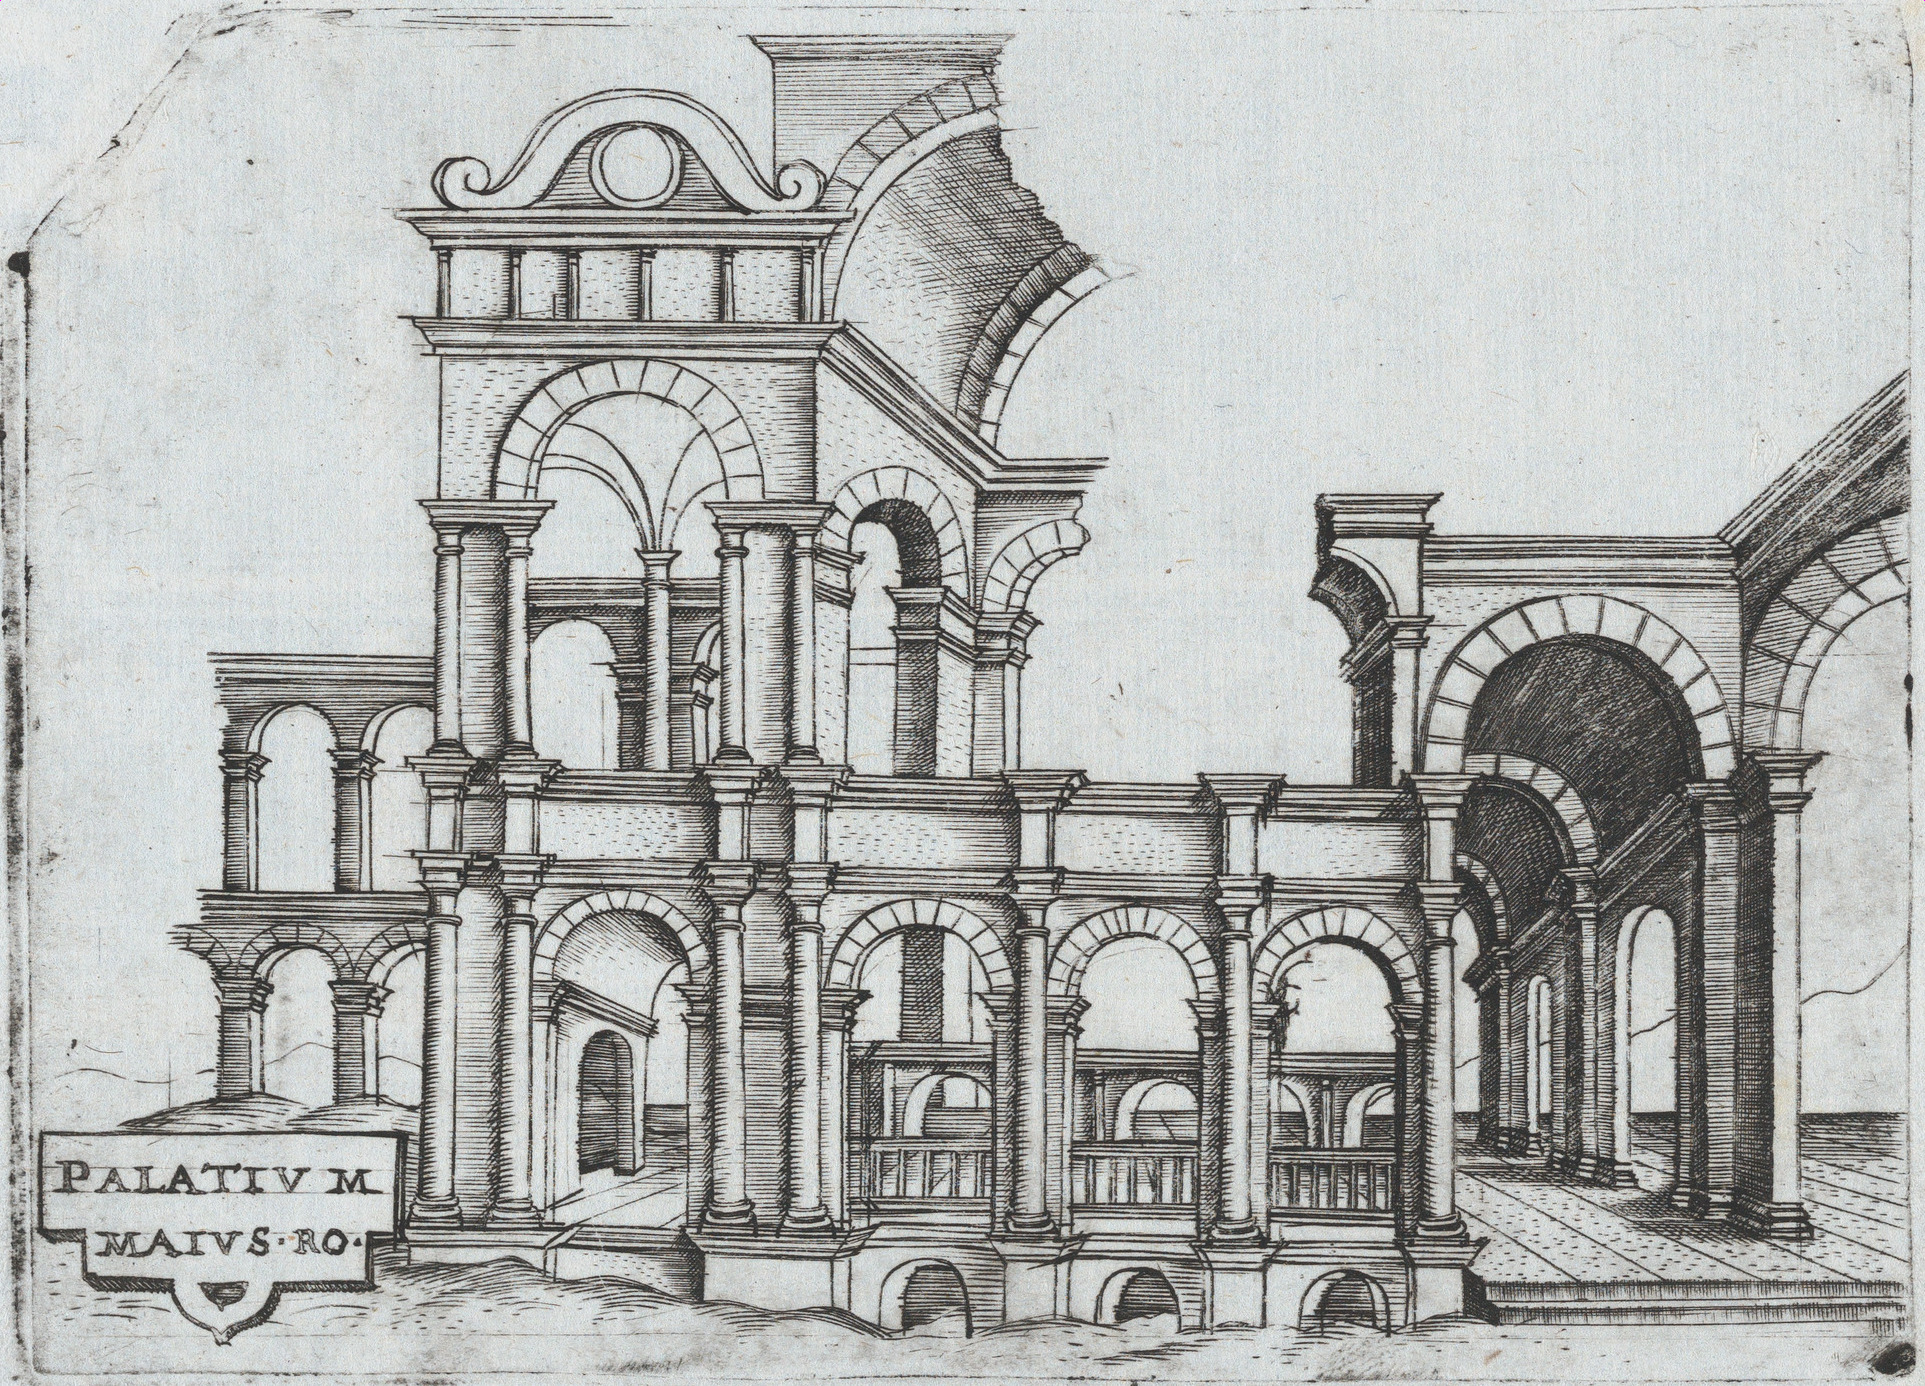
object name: album print ornament architecture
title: Porta Antonae, from a series of prints depicting (reconstructed) buildings from Roman Antiquity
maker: monogrammist g.a. with the caltrop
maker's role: artist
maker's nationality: italian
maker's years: 1535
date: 1530-1550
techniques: engraving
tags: architecture,arches